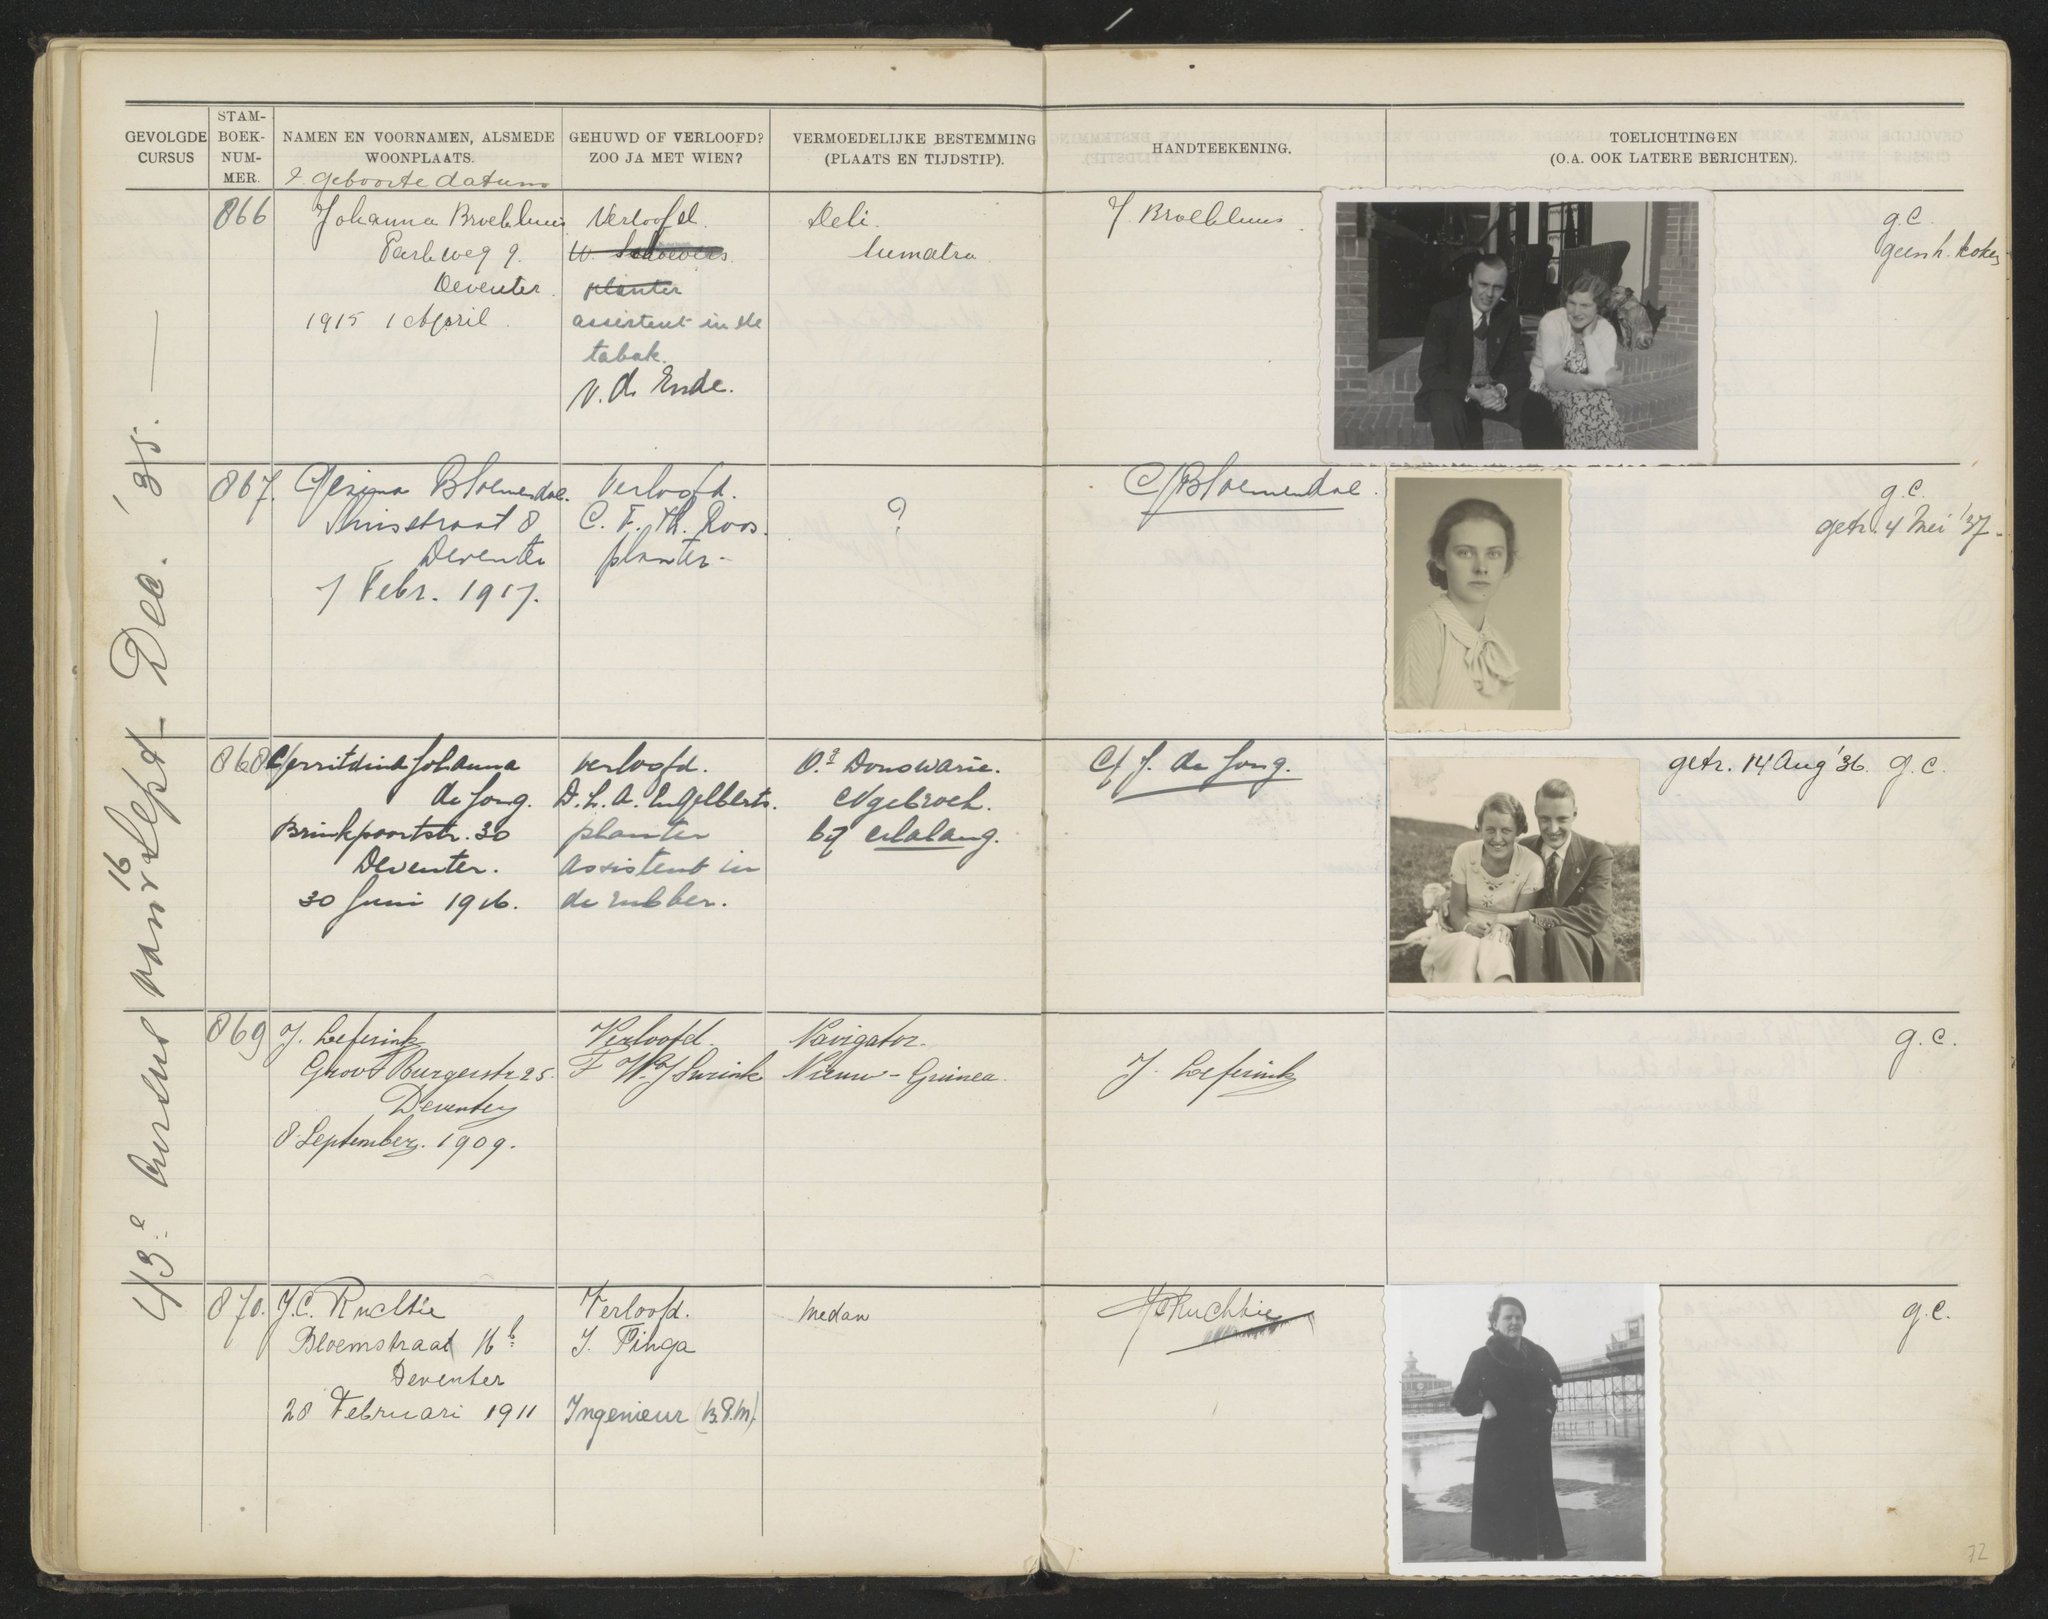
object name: photograph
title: Blad 72 uit Stamboek van de leerlingen der Koloniale School voor Meisjes en Vrouwen te 's-Gravenhage deel II (1930-1949)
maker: Anonymous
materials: paper, photographic support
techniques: photography, printing, writing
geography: the hague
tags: further education (+ pupil), further education, the hague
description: Twee pagina's met gegevens van de deelnemers aan de 43e driemaandelijkse cursus van september tot december 1935, stamboeknummers 866 tot en met 870. Onderdeel van Stamboek van de leerlingen der Koloniale School voor Meisjes en Vrouwen te 's-Gravenhage deel II (1930-1949).